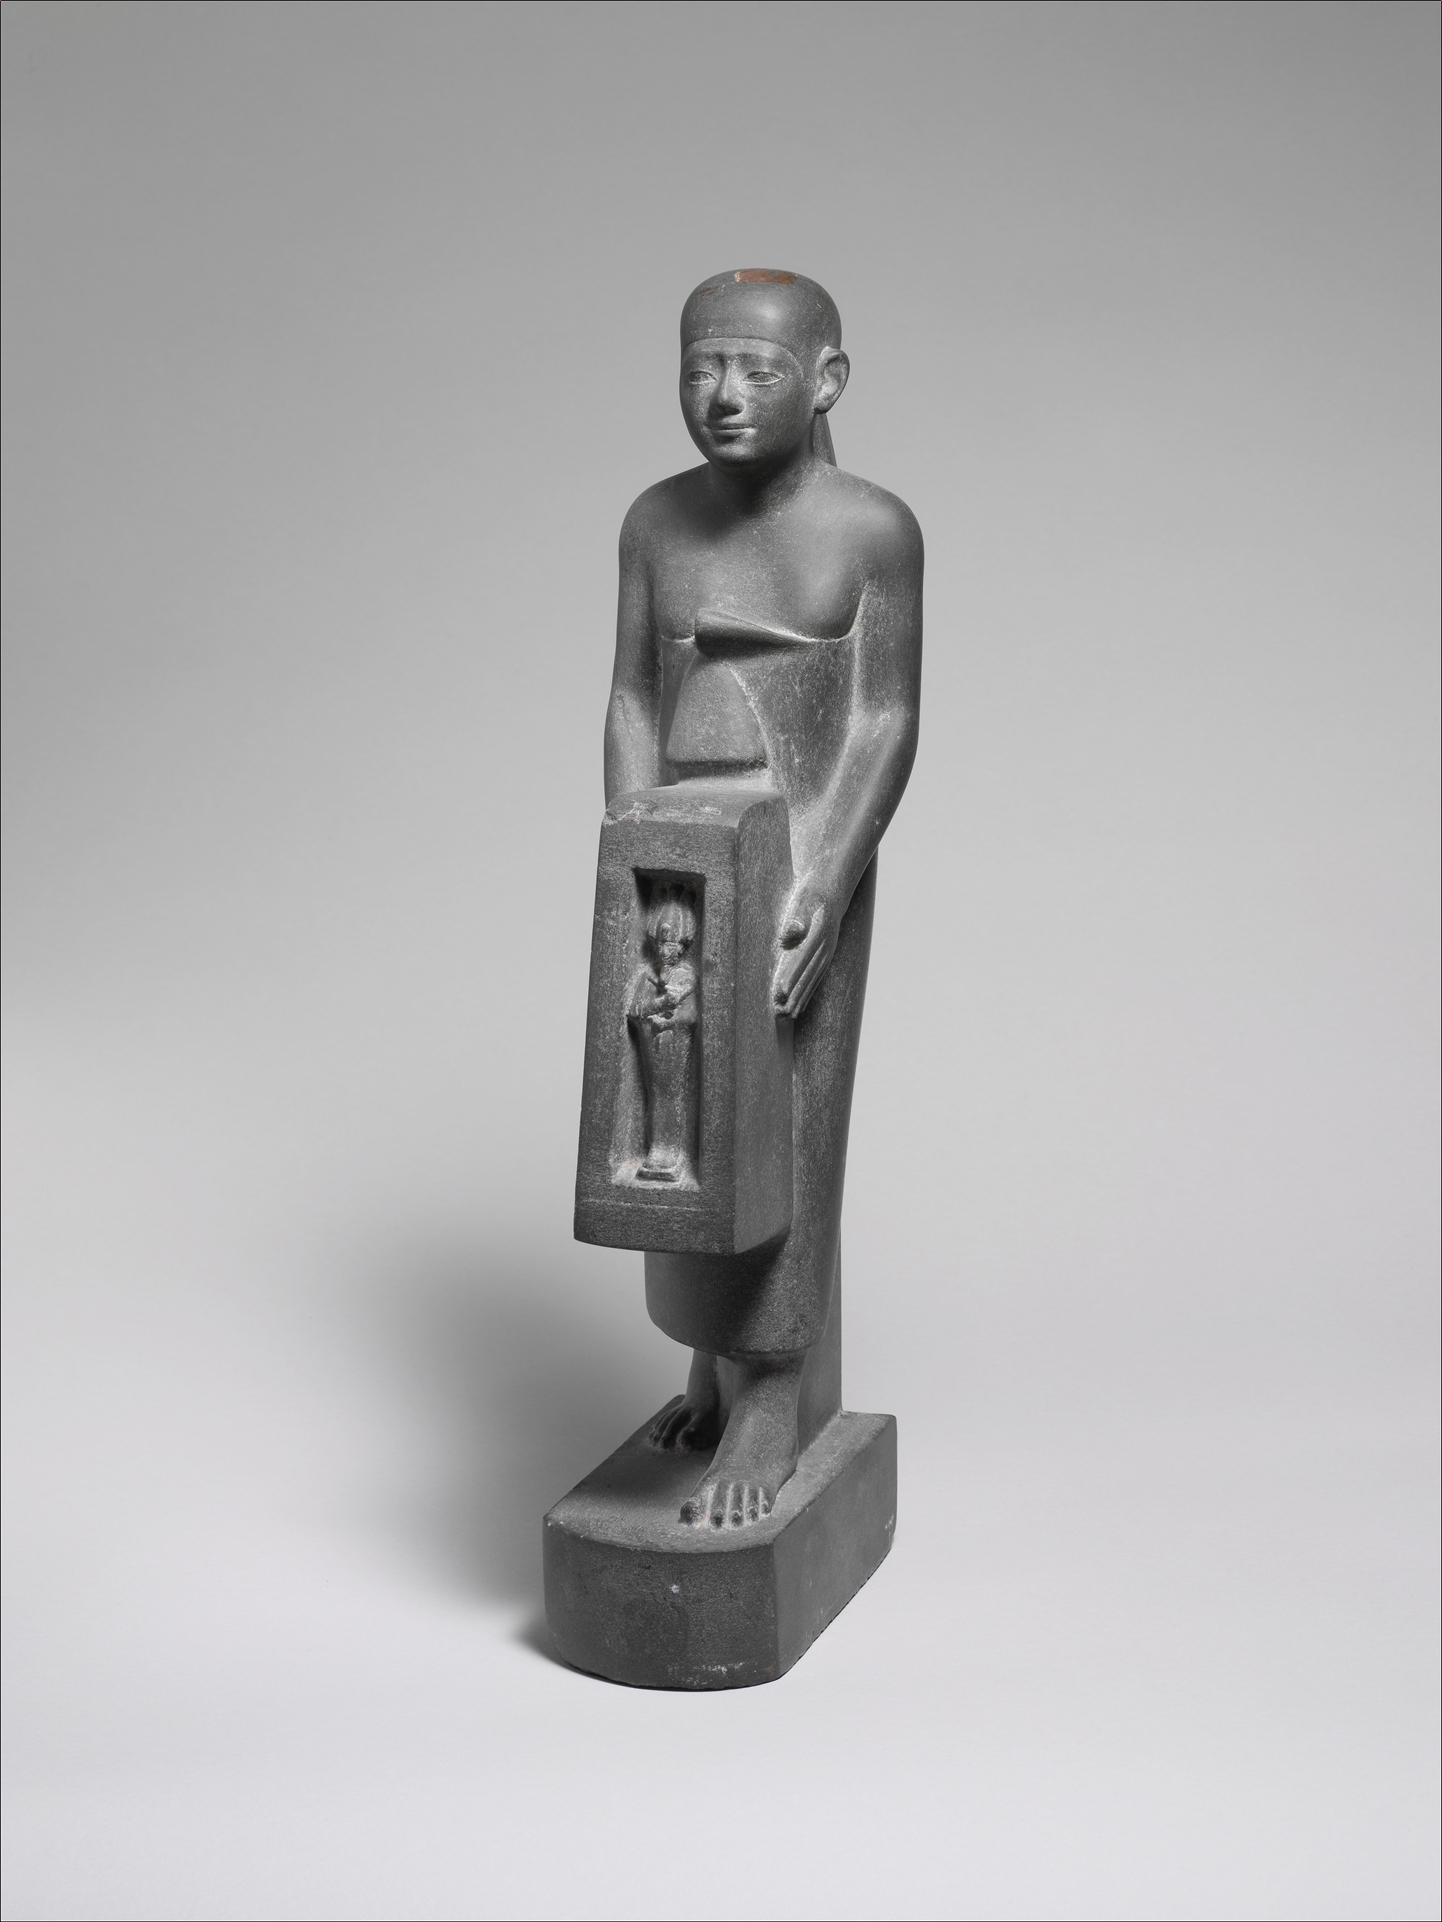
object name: statue, priest, osiris shrine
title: Man Holding a Shrine Containing an Image of Osiris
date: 500-301 BCE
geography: egypt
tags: men